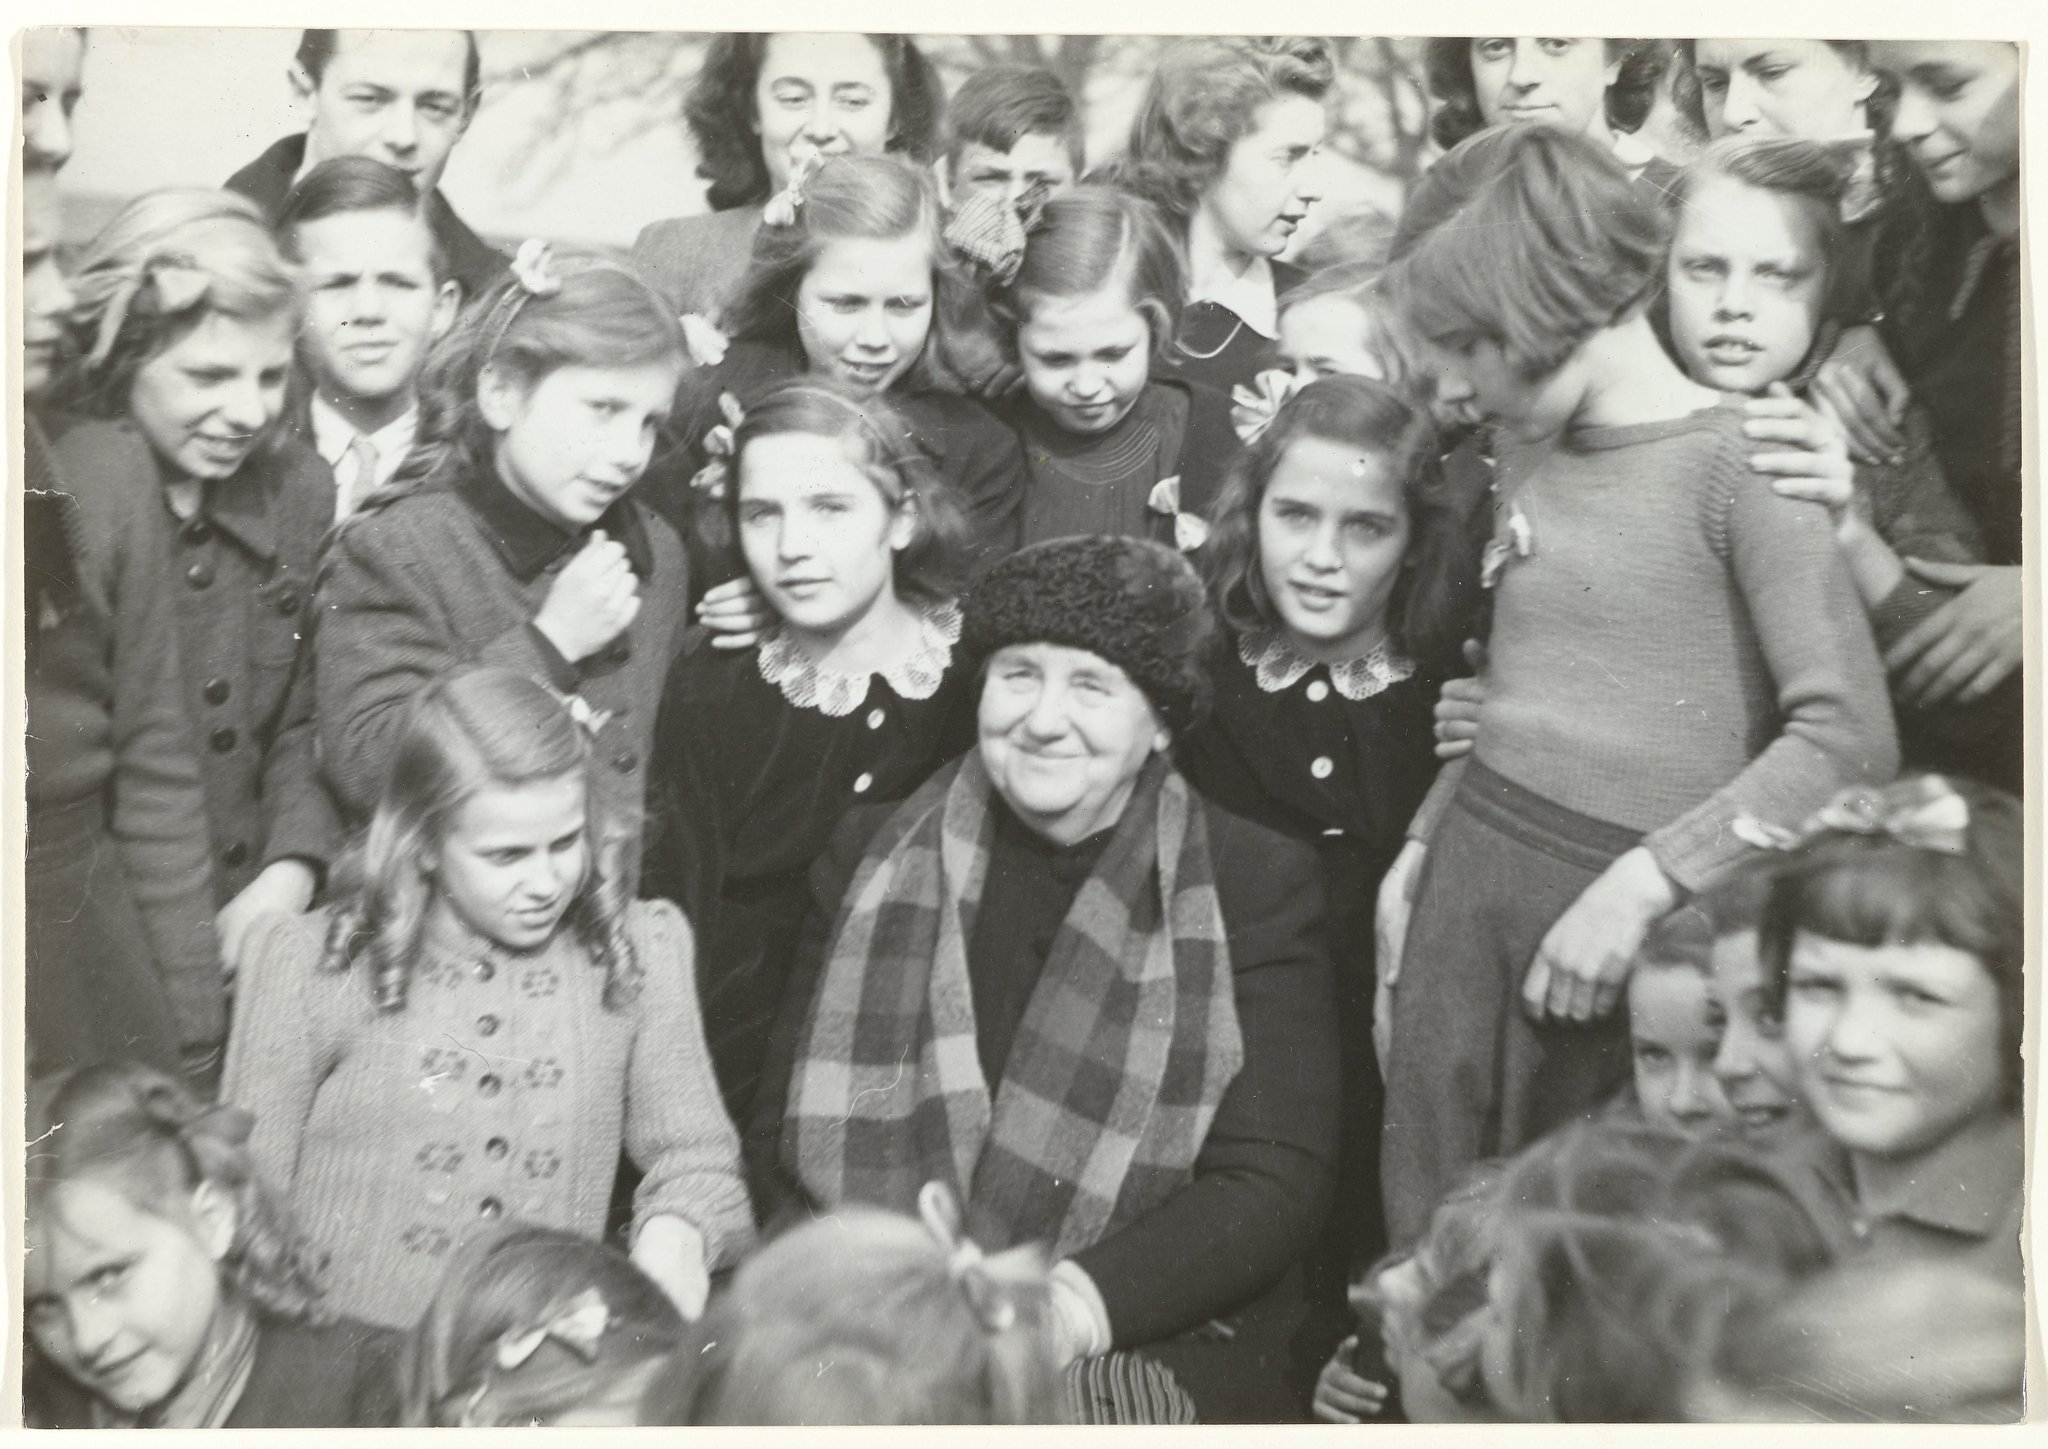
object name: photograph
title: Kamp voor Nederlandse kinderen in Engeland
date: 1911-1945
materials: photographic support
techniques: photography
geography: england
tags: the hague, print maker, wilhelmina of the netherlands, england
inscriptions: inscription, stamp: ‘COPYRIGHT / 'ANEFO' / ALGEMEEN NEDERLANDSCH FOTOBUREAU’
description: Koningin Wilhelmina op bezoek in een kamp voor Nederlandse kinderen in Engeland. Zij waren uit het al in 1944 bevrijde zuidelijke deel van Nederland naar Engeland gekomen voor herstel.